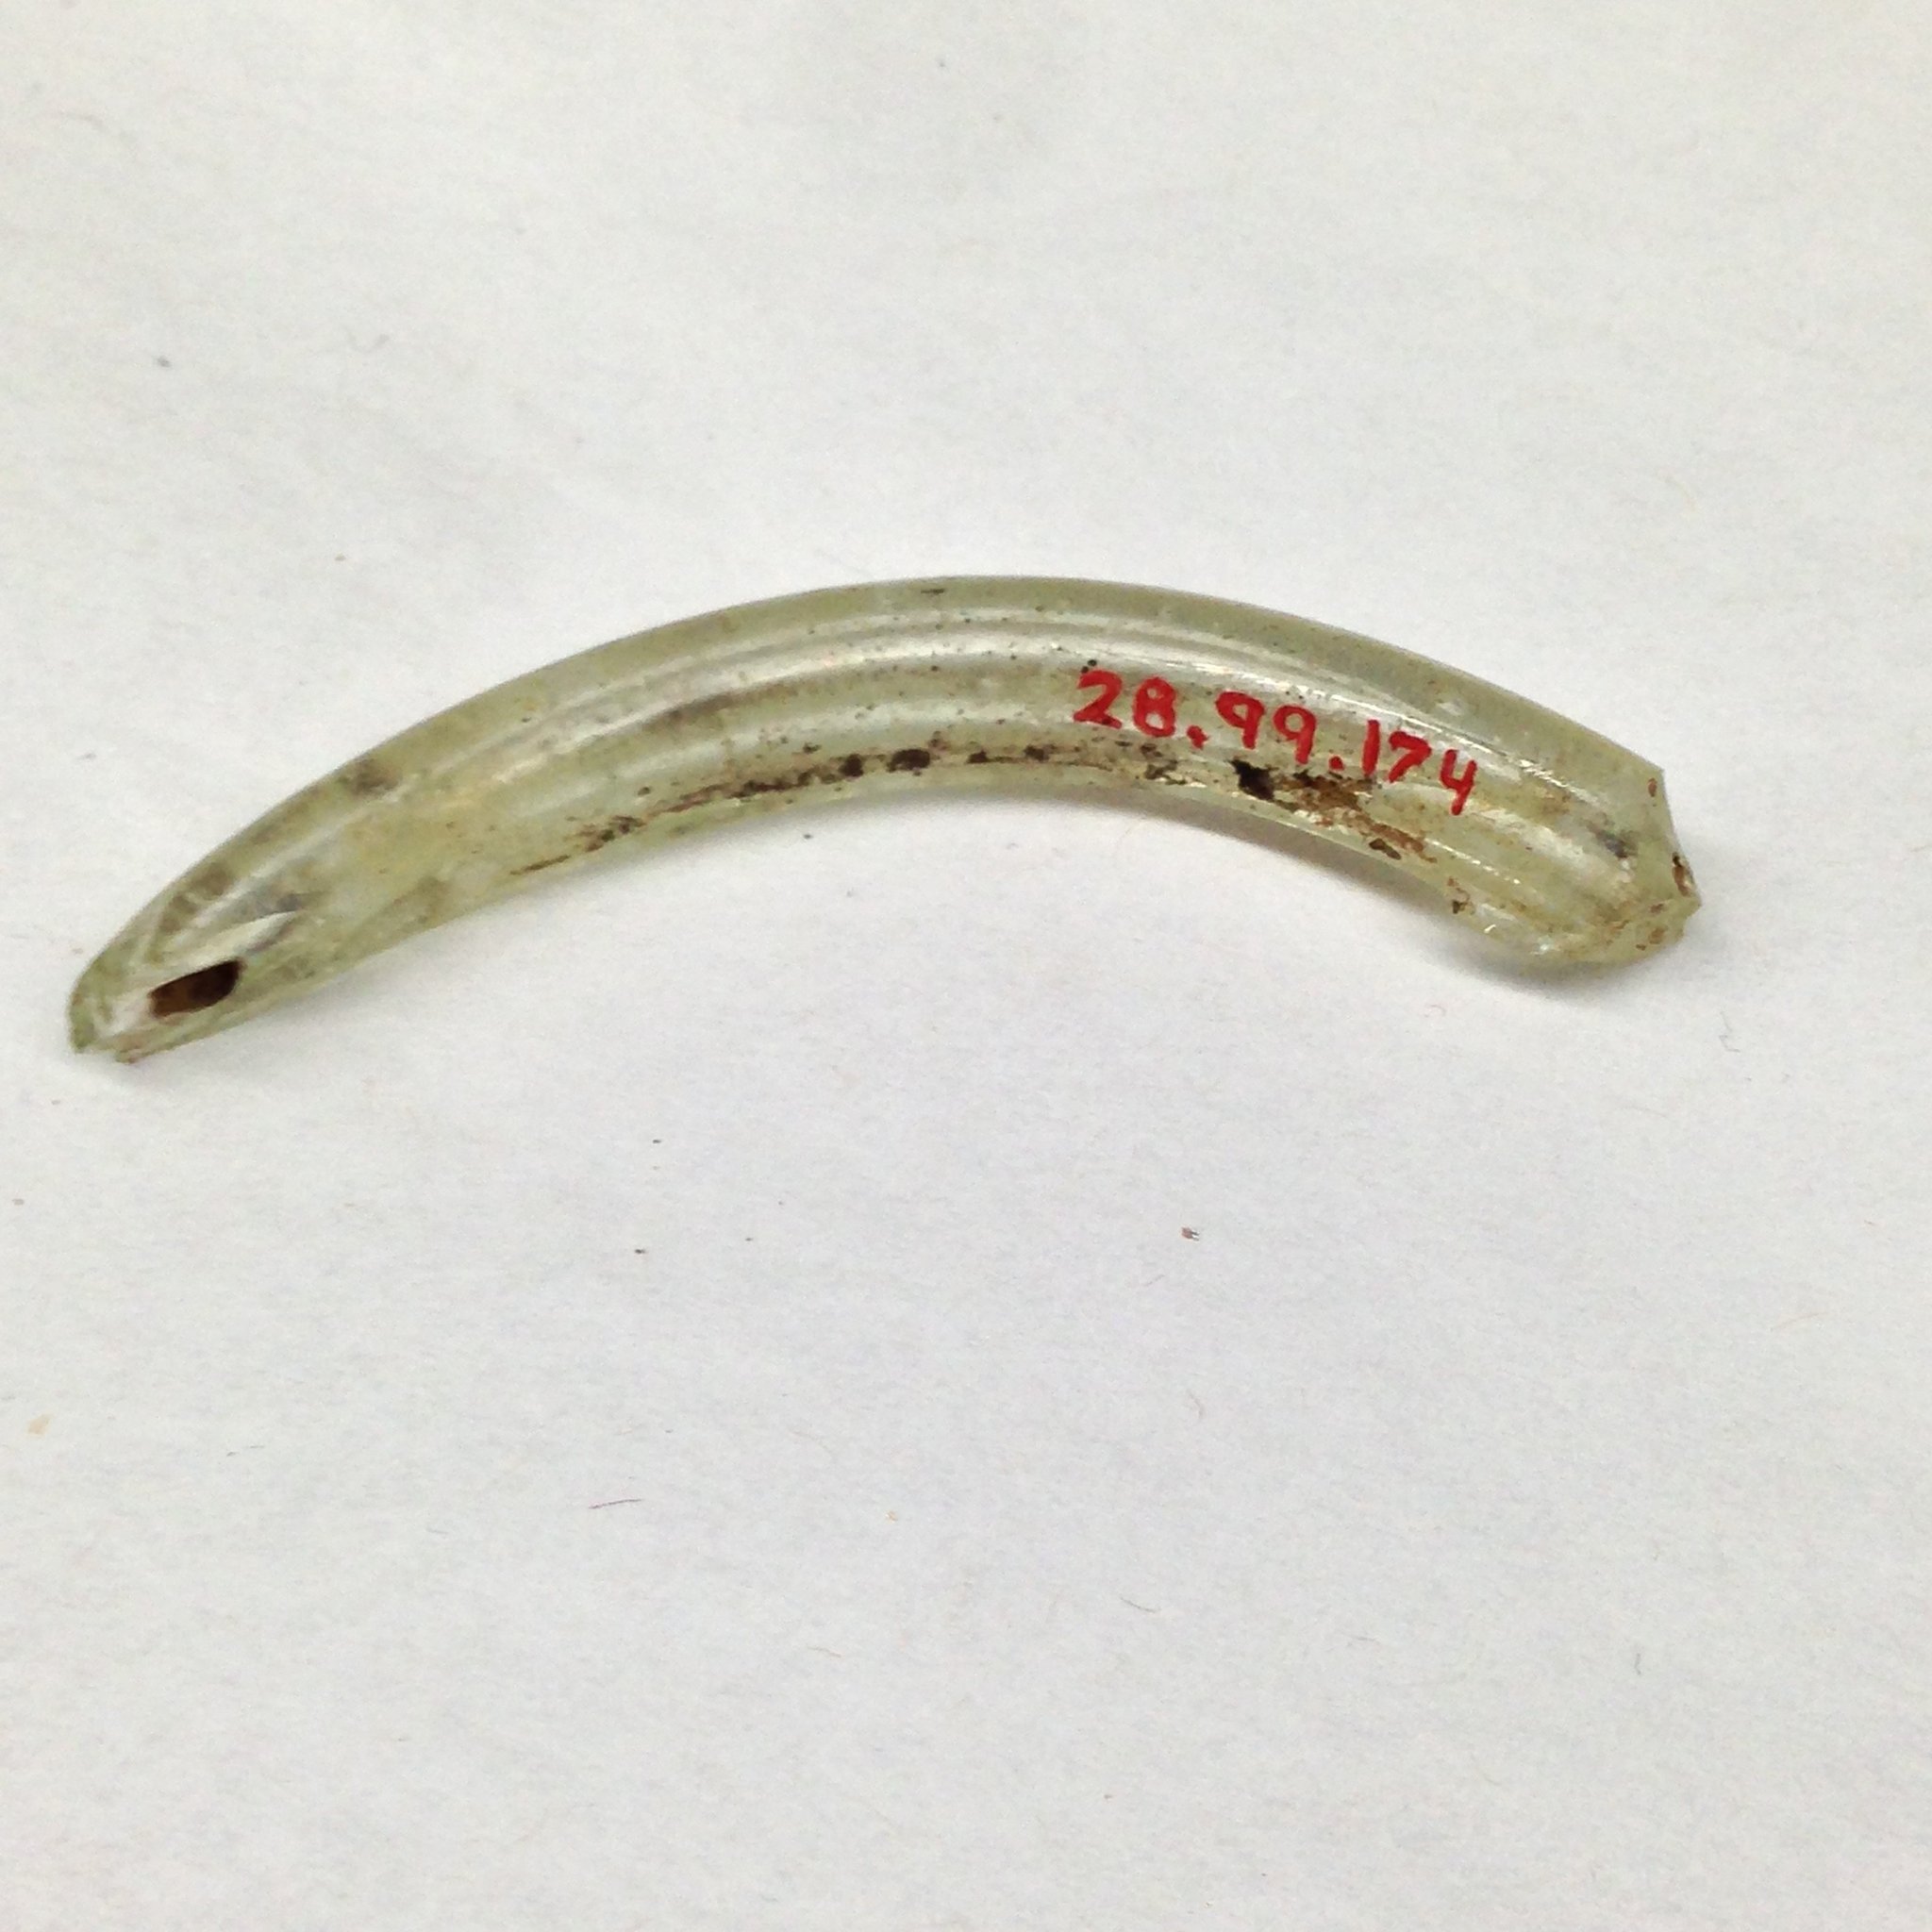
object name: fragment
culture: european or middle eastern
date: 1150-1250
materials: ceramic, glass